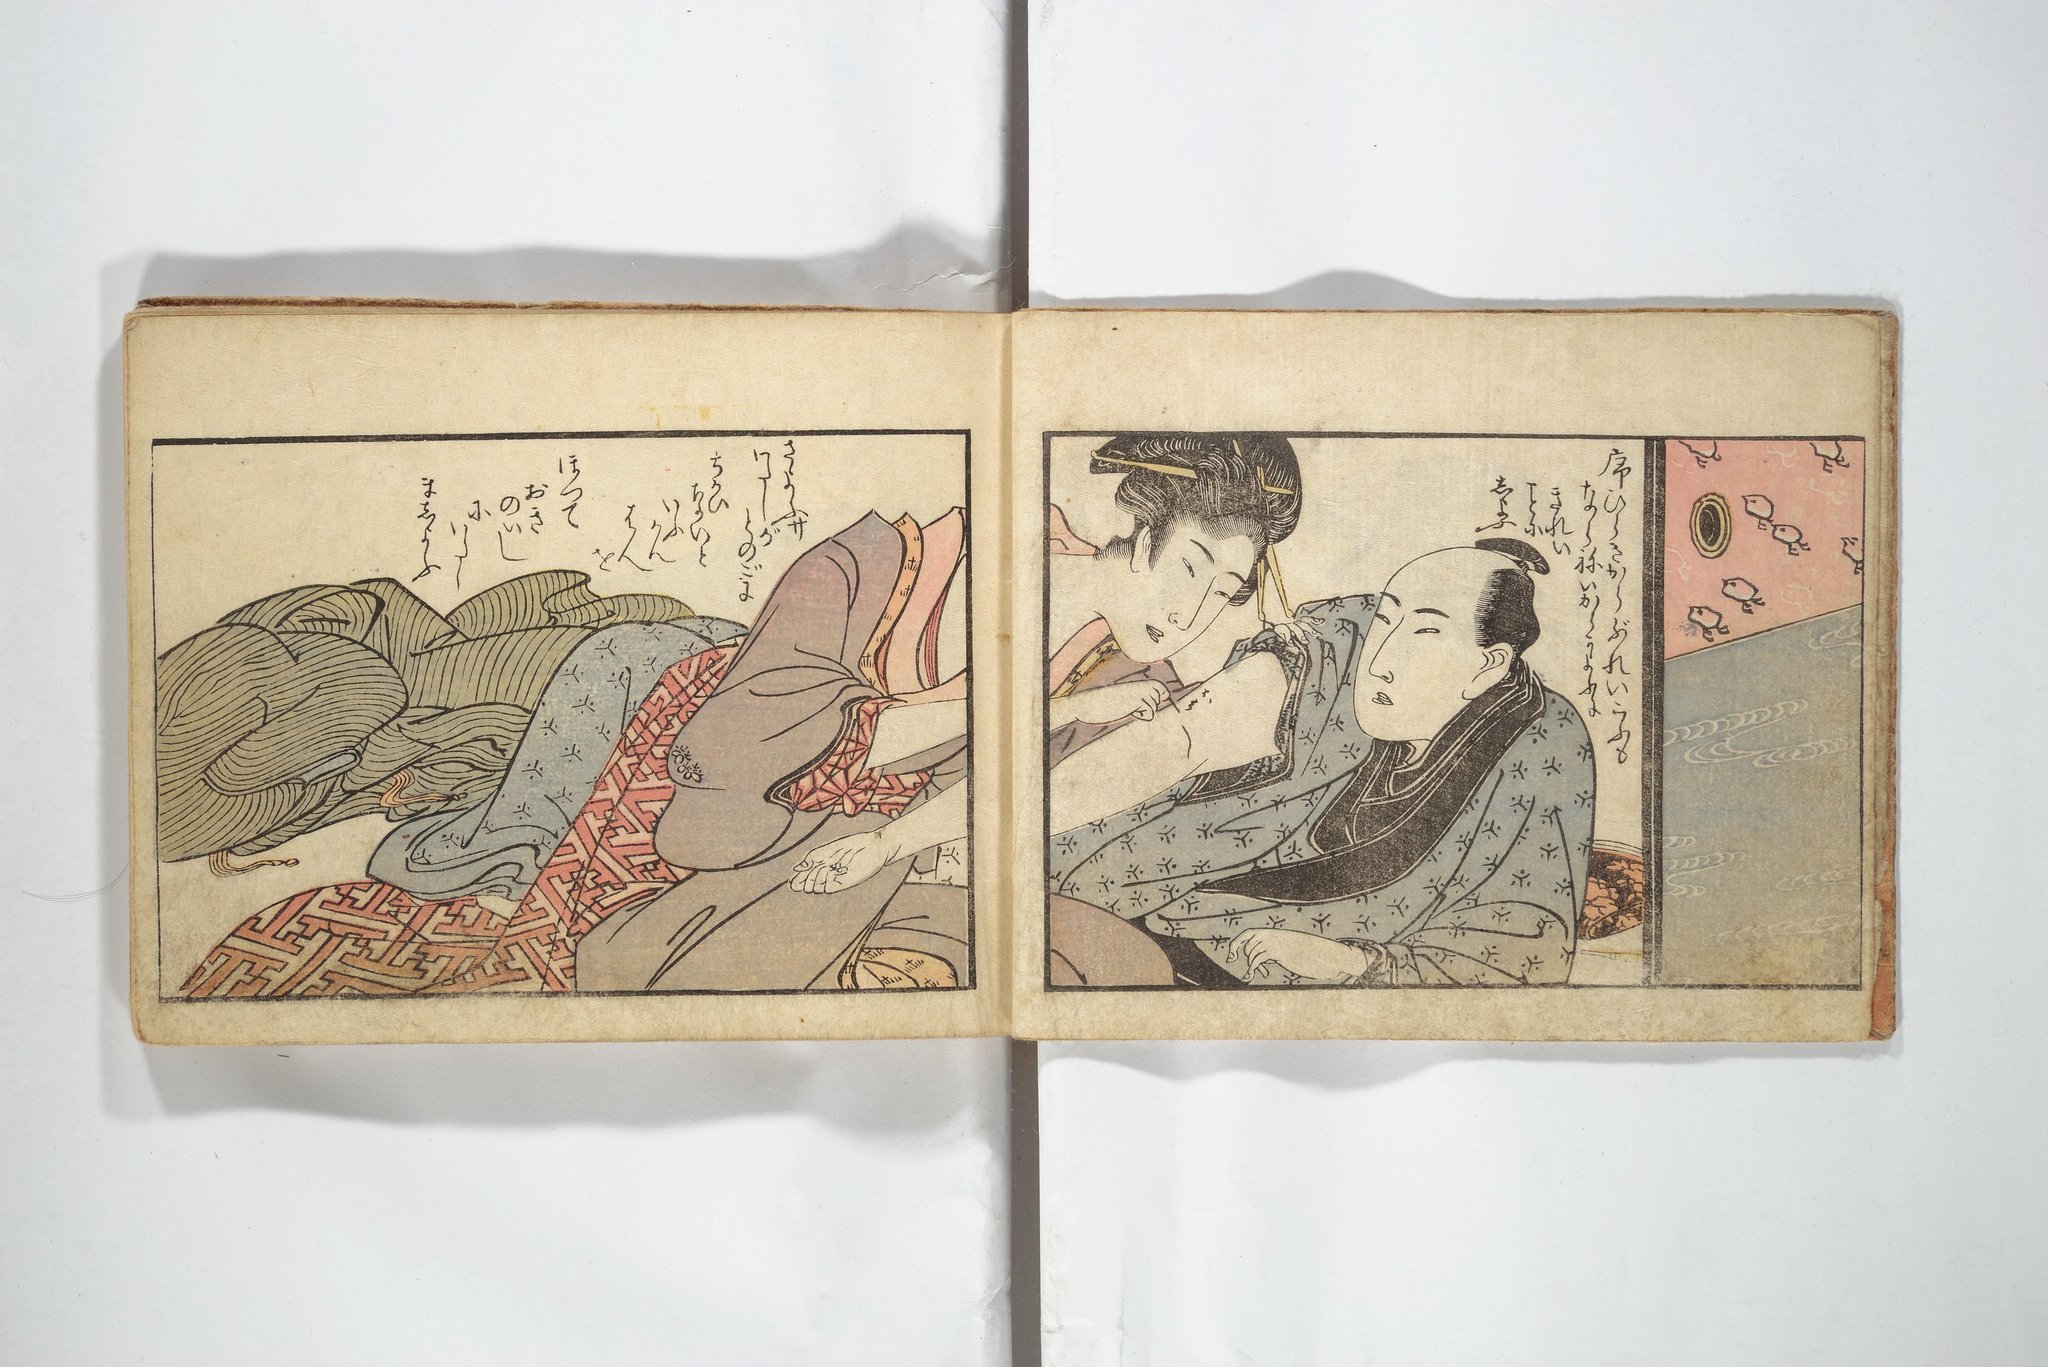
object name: illustrated book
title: Untitled Book of Erotica (Shunga) 春画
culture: japanese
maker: utagawa toyokuni i 歌川豊国一世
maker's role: artist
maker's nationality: japanese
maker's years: 1769-1825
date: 1798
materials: ink, paper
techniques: woodblock print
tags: men,women